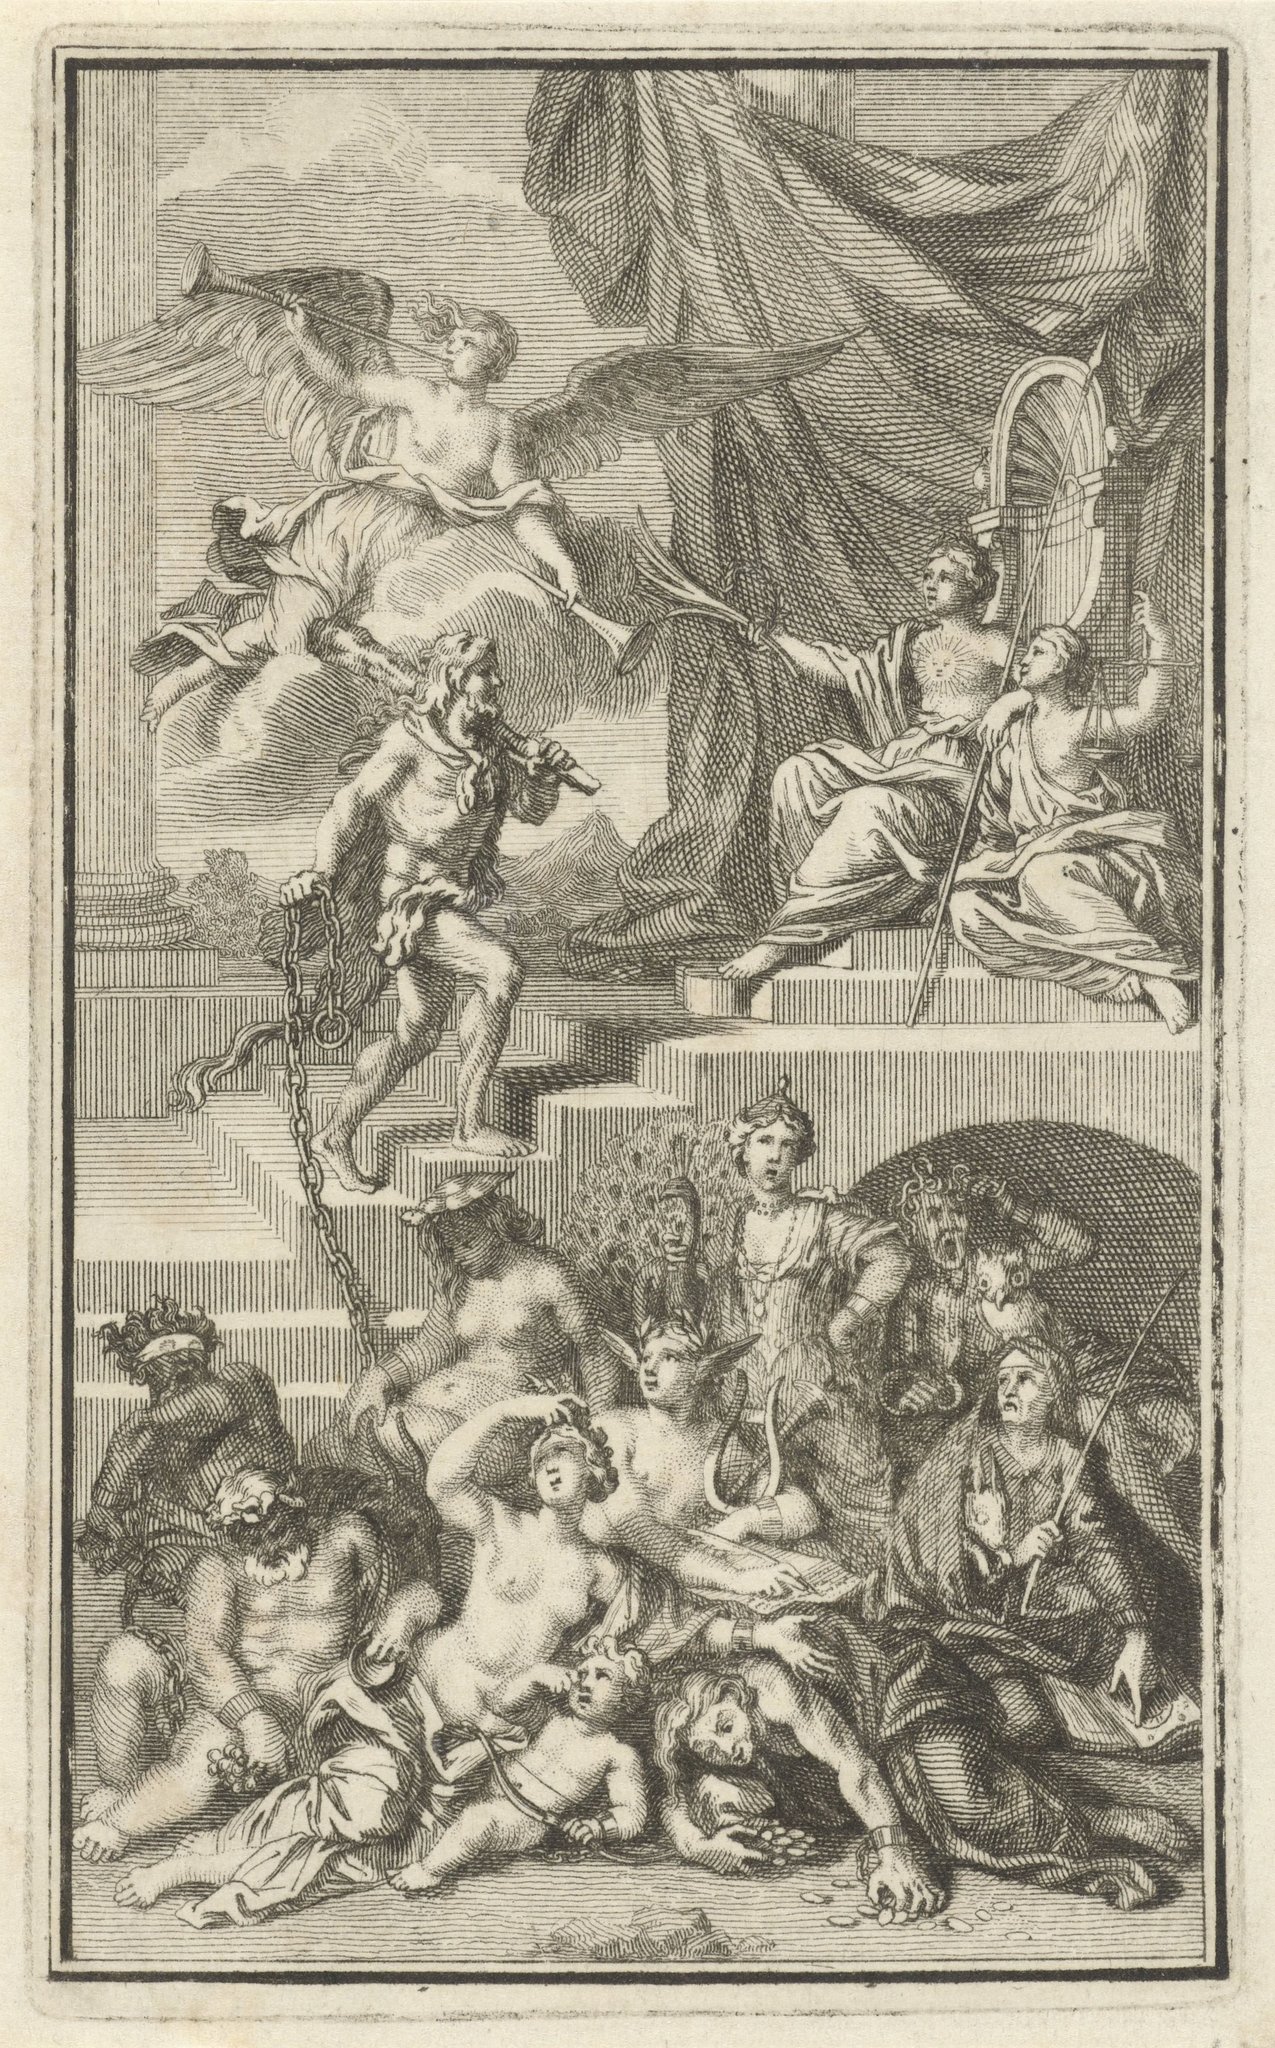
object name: print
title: Allegorische voorstelling met Hercules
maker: bernard picart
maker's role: draughtsman, print maker, publisher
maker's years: 1673-1733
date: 1714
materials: paper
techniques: engraving, etching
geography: amsterdam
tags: truth; 'verità' (ripa), justice; 'forza alla giustitia sottoposta', 'giustitia', 'giustitia retta', 'giustitia rigorosa', 'impietà e violenza soggetta alla giustitia' (ripa), the seven deadly sins (personified), fame; 'fama', 'fama buona', 'fama chiara' (ripa)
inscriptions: collector's mark: Lugt 240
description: Hercules leidt de zeven hoofdzonden aan een ketting mee naar Waarheid en Rechtvaardigheid. Zij zitten op een troon en kijken op naar Faam. Zij vliegt in de lucht en blaast de bazuin.